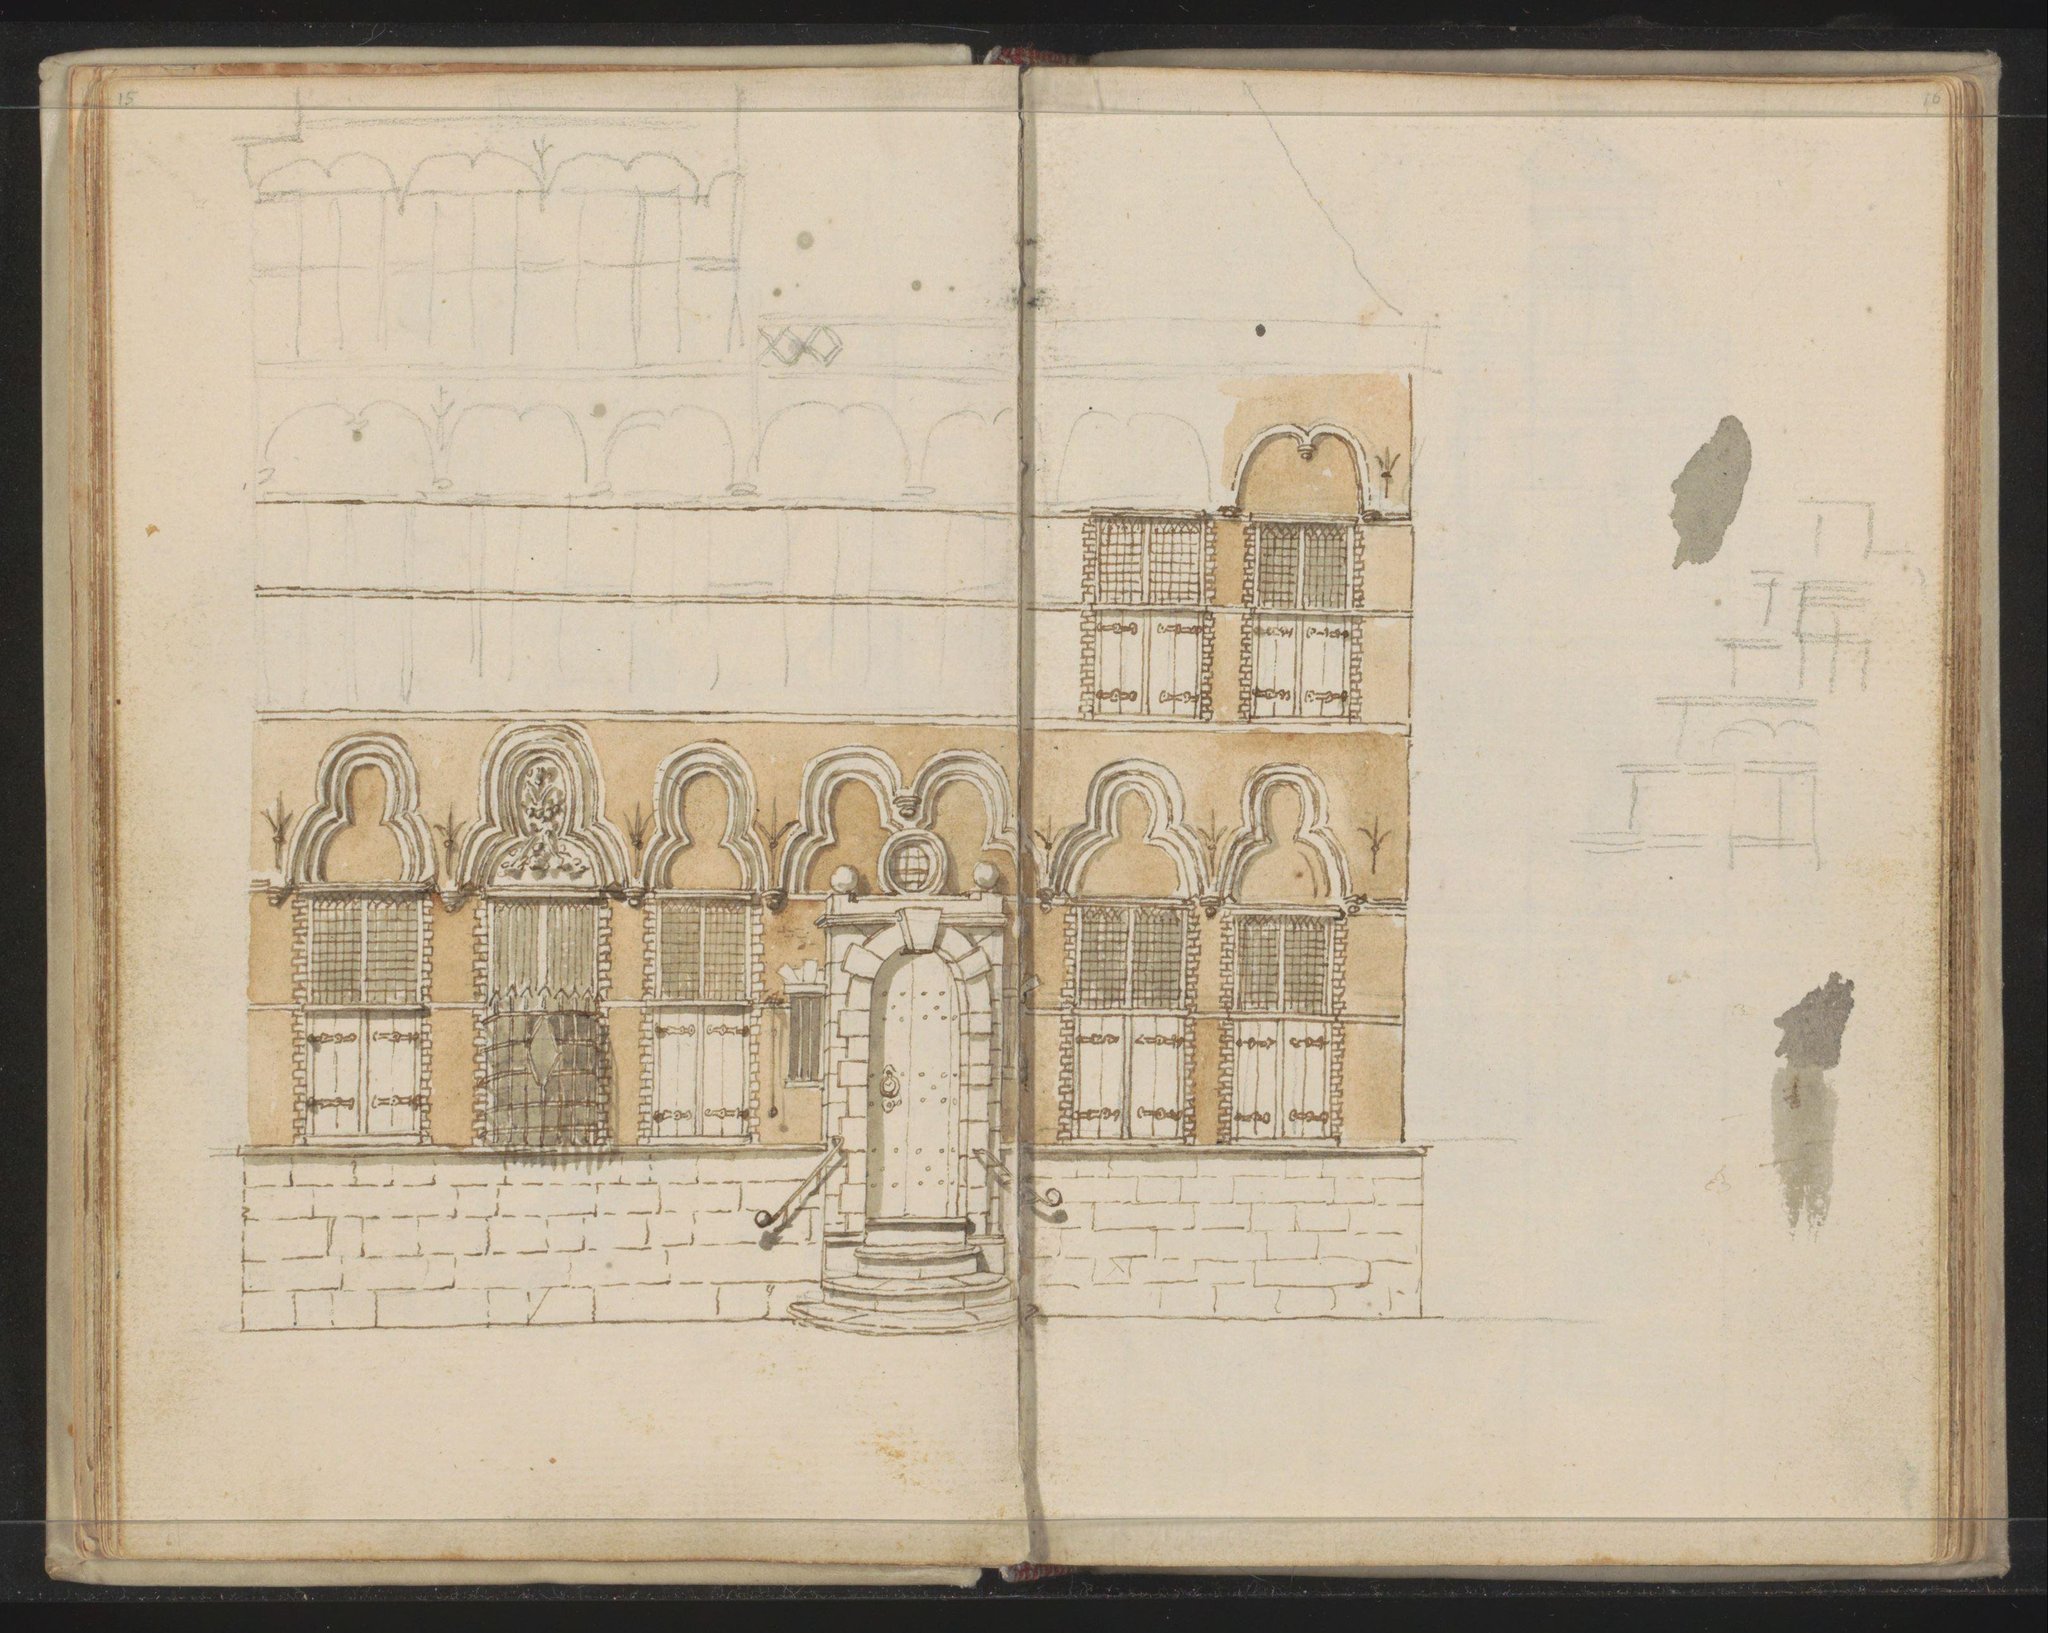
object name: sketchbook leaf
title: Opstand van een voorgevel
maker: johannes huibert prins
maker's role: draughtsman, painter, print maker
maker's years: 1757-1806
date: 1783-1797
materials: ink, paper, pencil, watercolor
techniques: brush, pen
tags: ornament ~ tracery, façade (of house or building)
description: De ruimte boven de vensters op de begane grond is gedecoreerd met tracering. Pagina 15 en 16 uit een schetsboek met 175 pagina's.